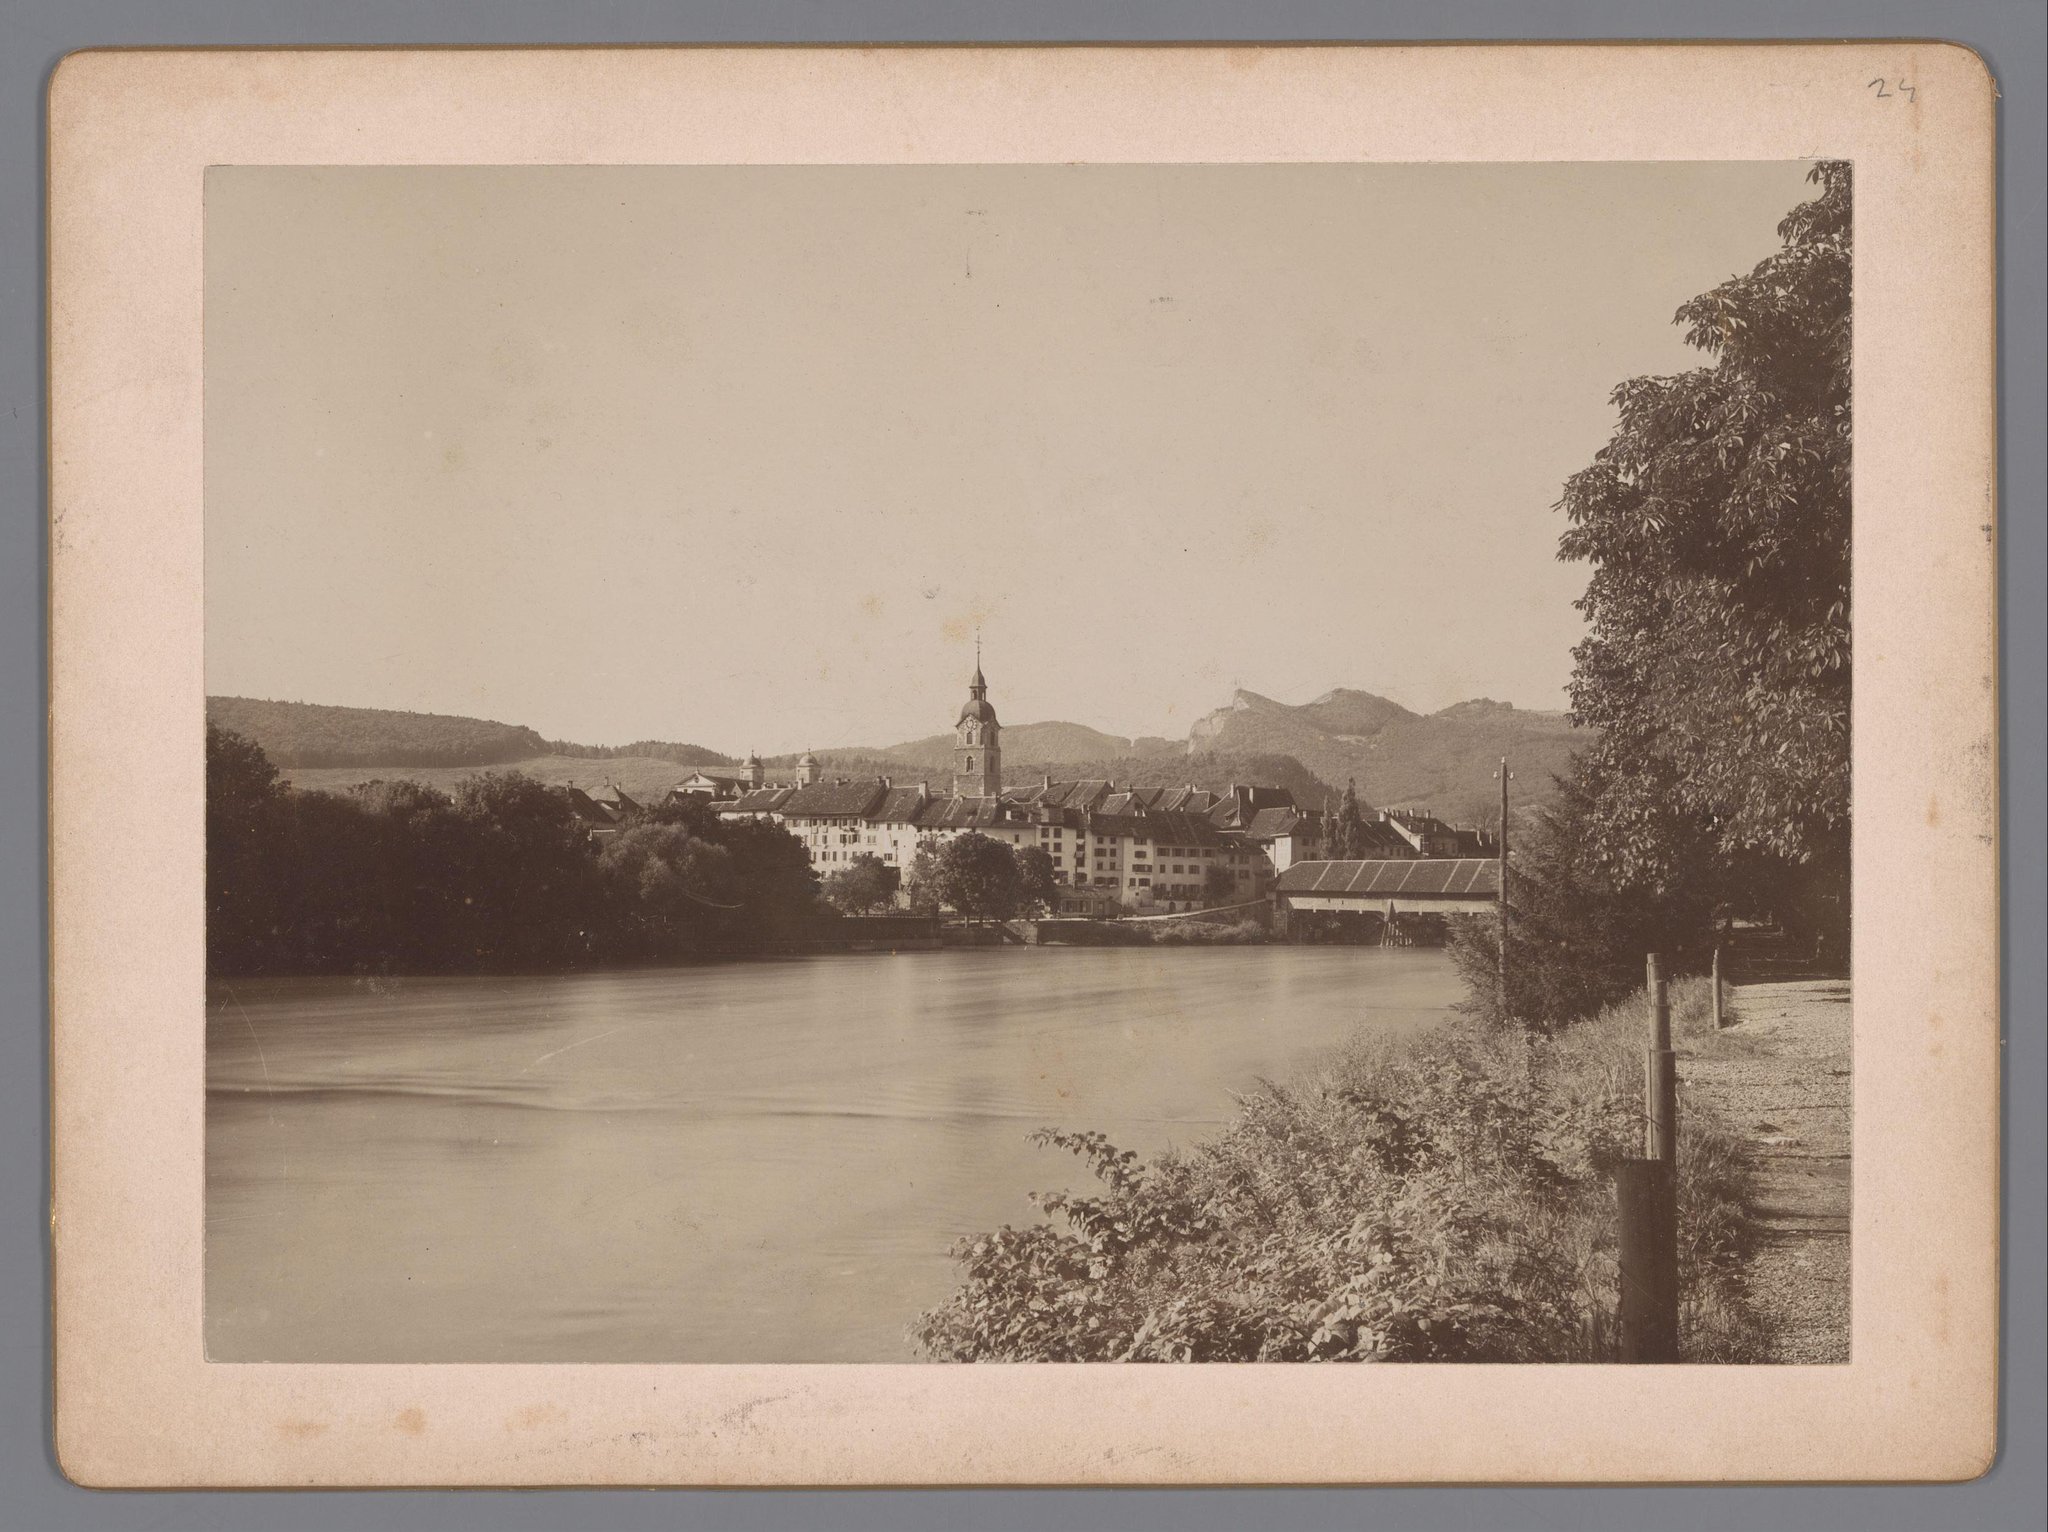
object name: photograph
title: Olten bij Aarau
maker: Anonymous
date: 1890-1930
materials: paper, cardboard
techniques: gelatin silver print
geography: olten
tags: city-view in general; 'veduta', river